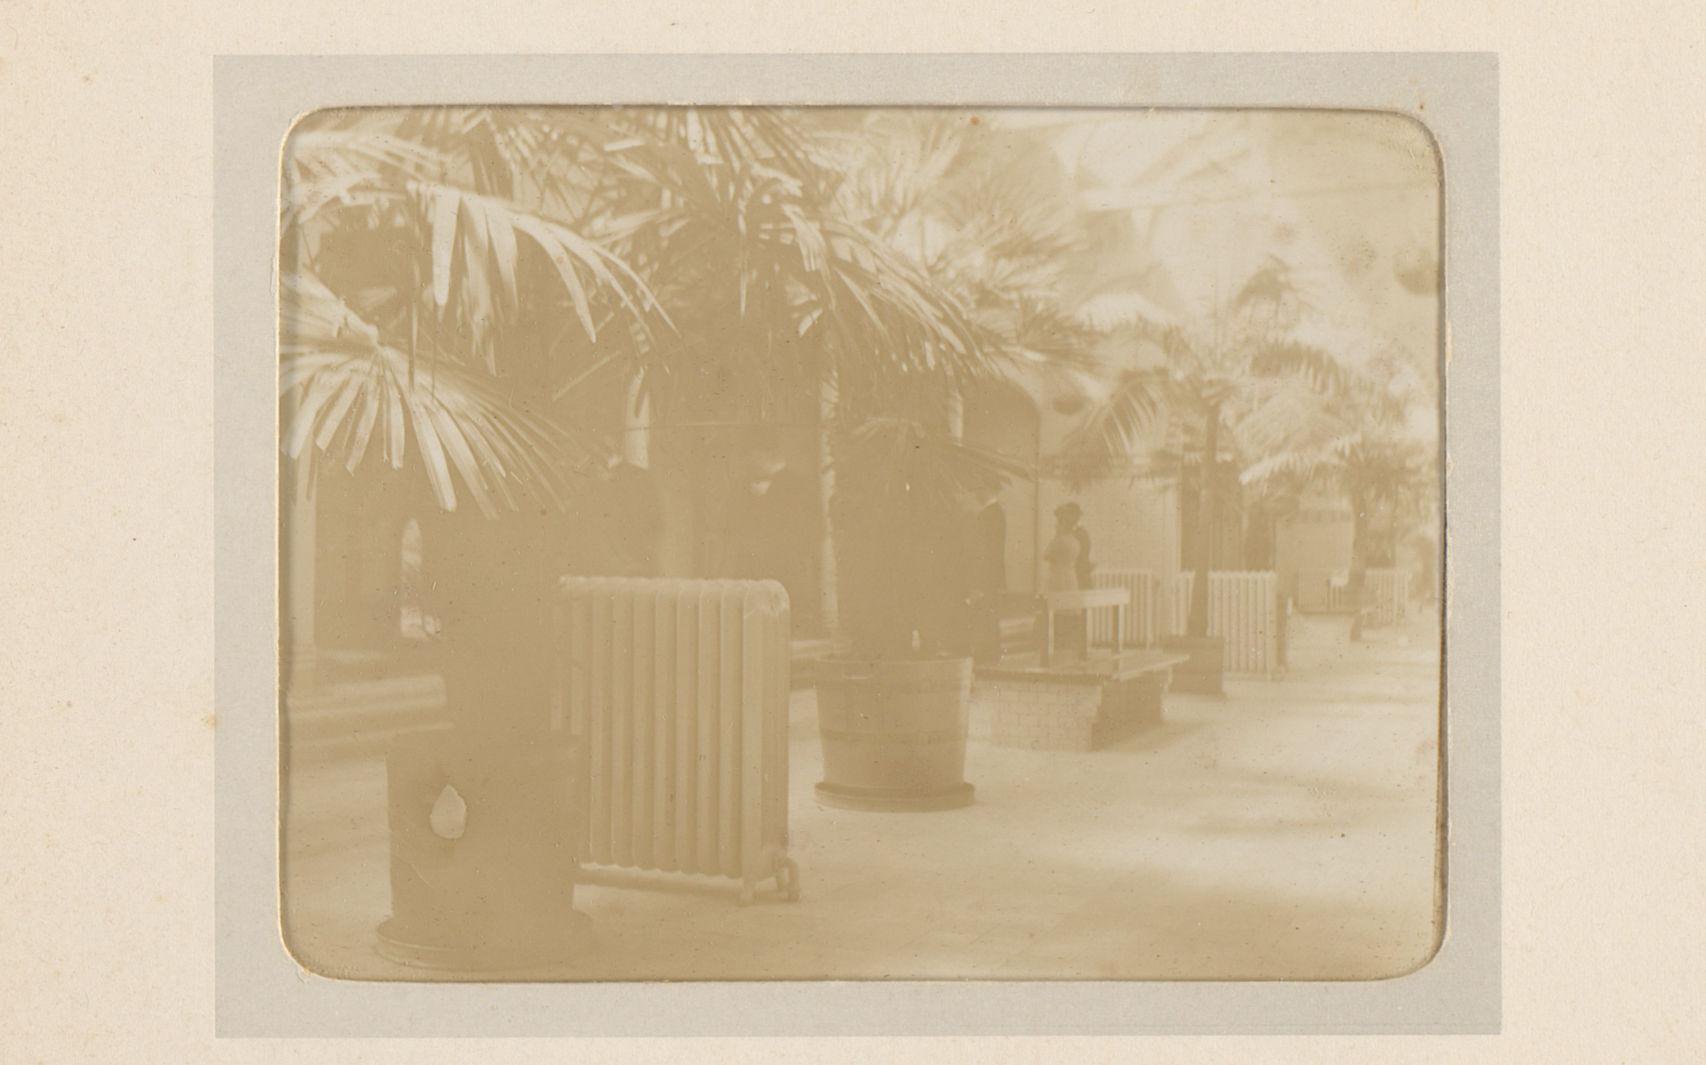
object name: photograph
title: Interieur van het vogelhuis in Artis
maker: liesbeth overhoff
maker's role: fotograaf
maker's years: 1895-1969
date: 1911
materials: paper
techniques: matte daylight collodion silver print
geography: amsterdam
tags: birds in a large cage, aviary, interior ~ representation of a building, zoo (as place of recreation)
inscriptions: inscription: ‘artis’